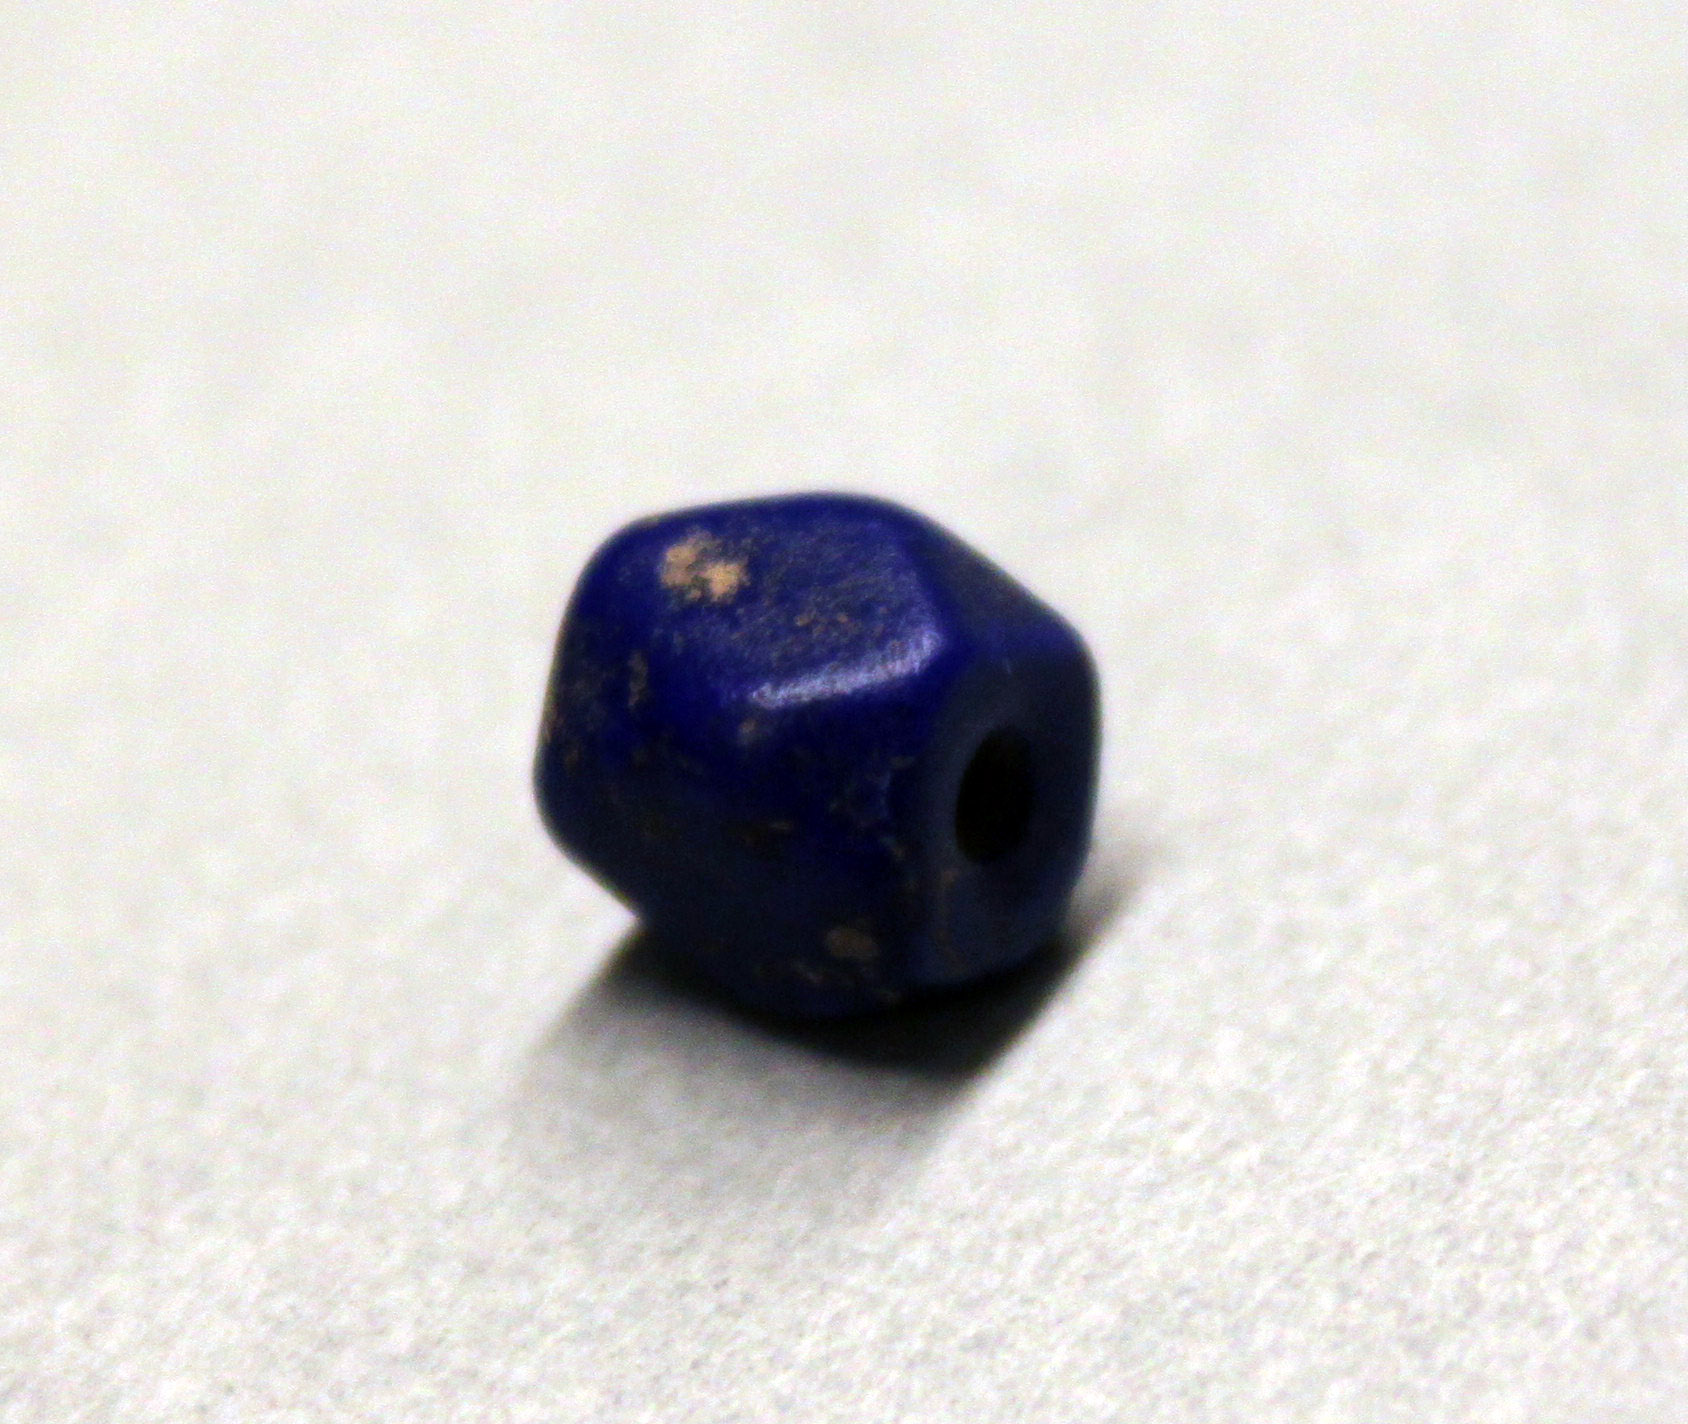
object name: bead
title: Beads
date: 801-1200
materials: lapis lazuli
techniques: cutting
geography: iran